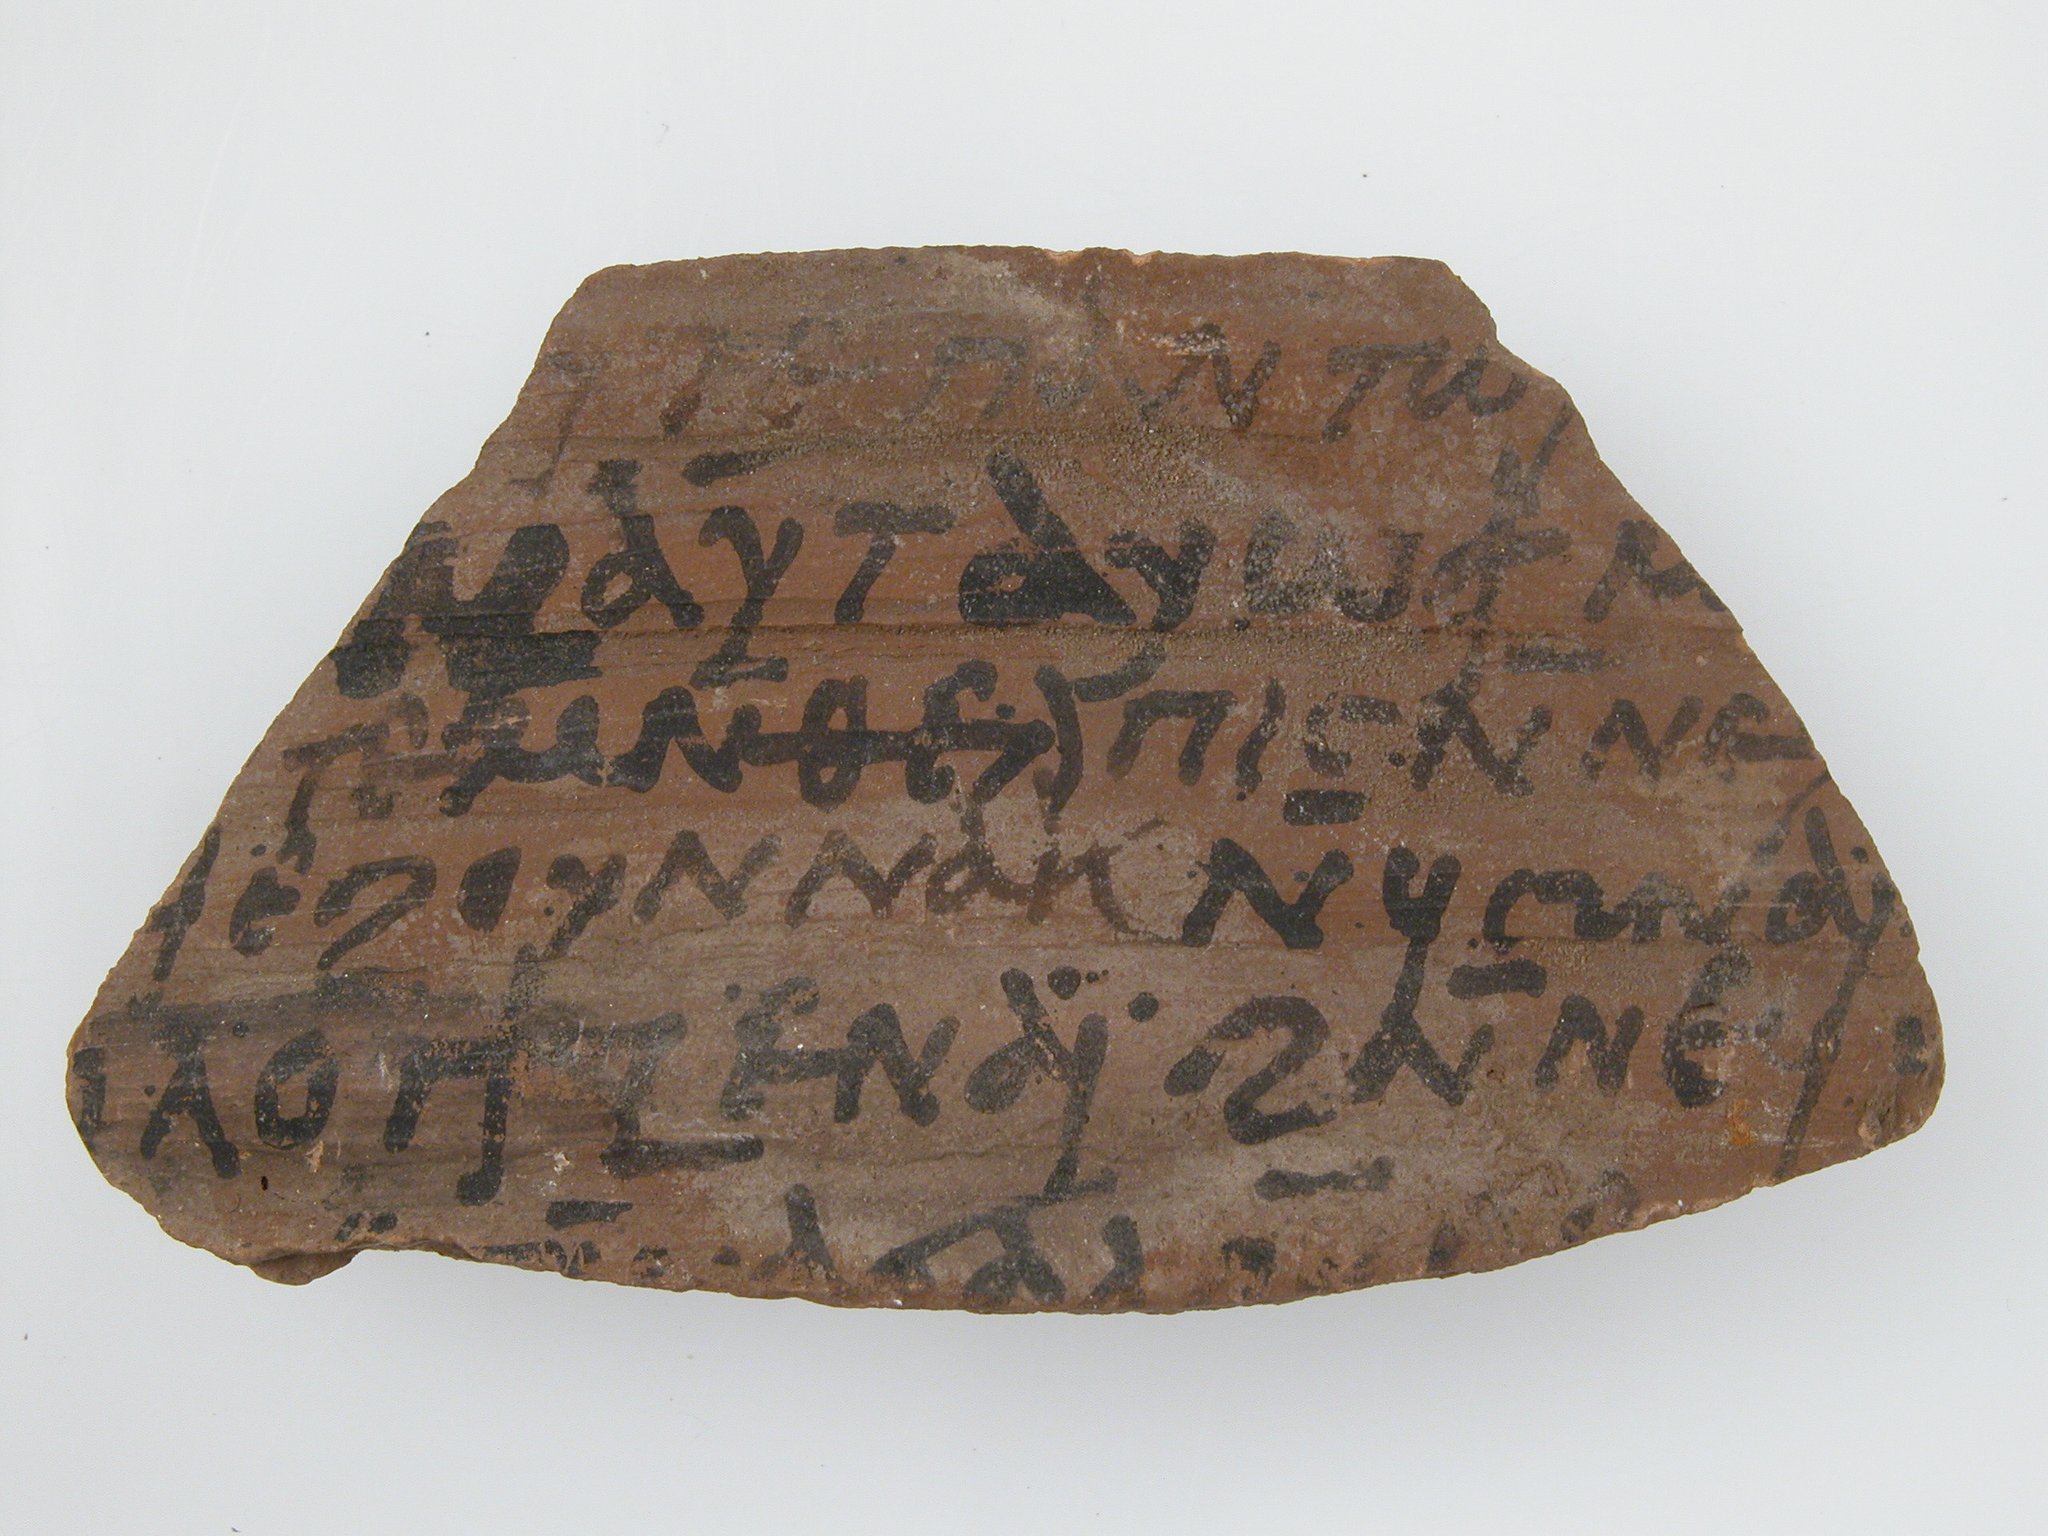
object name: ostrakon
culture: coptic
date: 600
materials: ink, pottery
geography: egypt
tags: coptic,documents